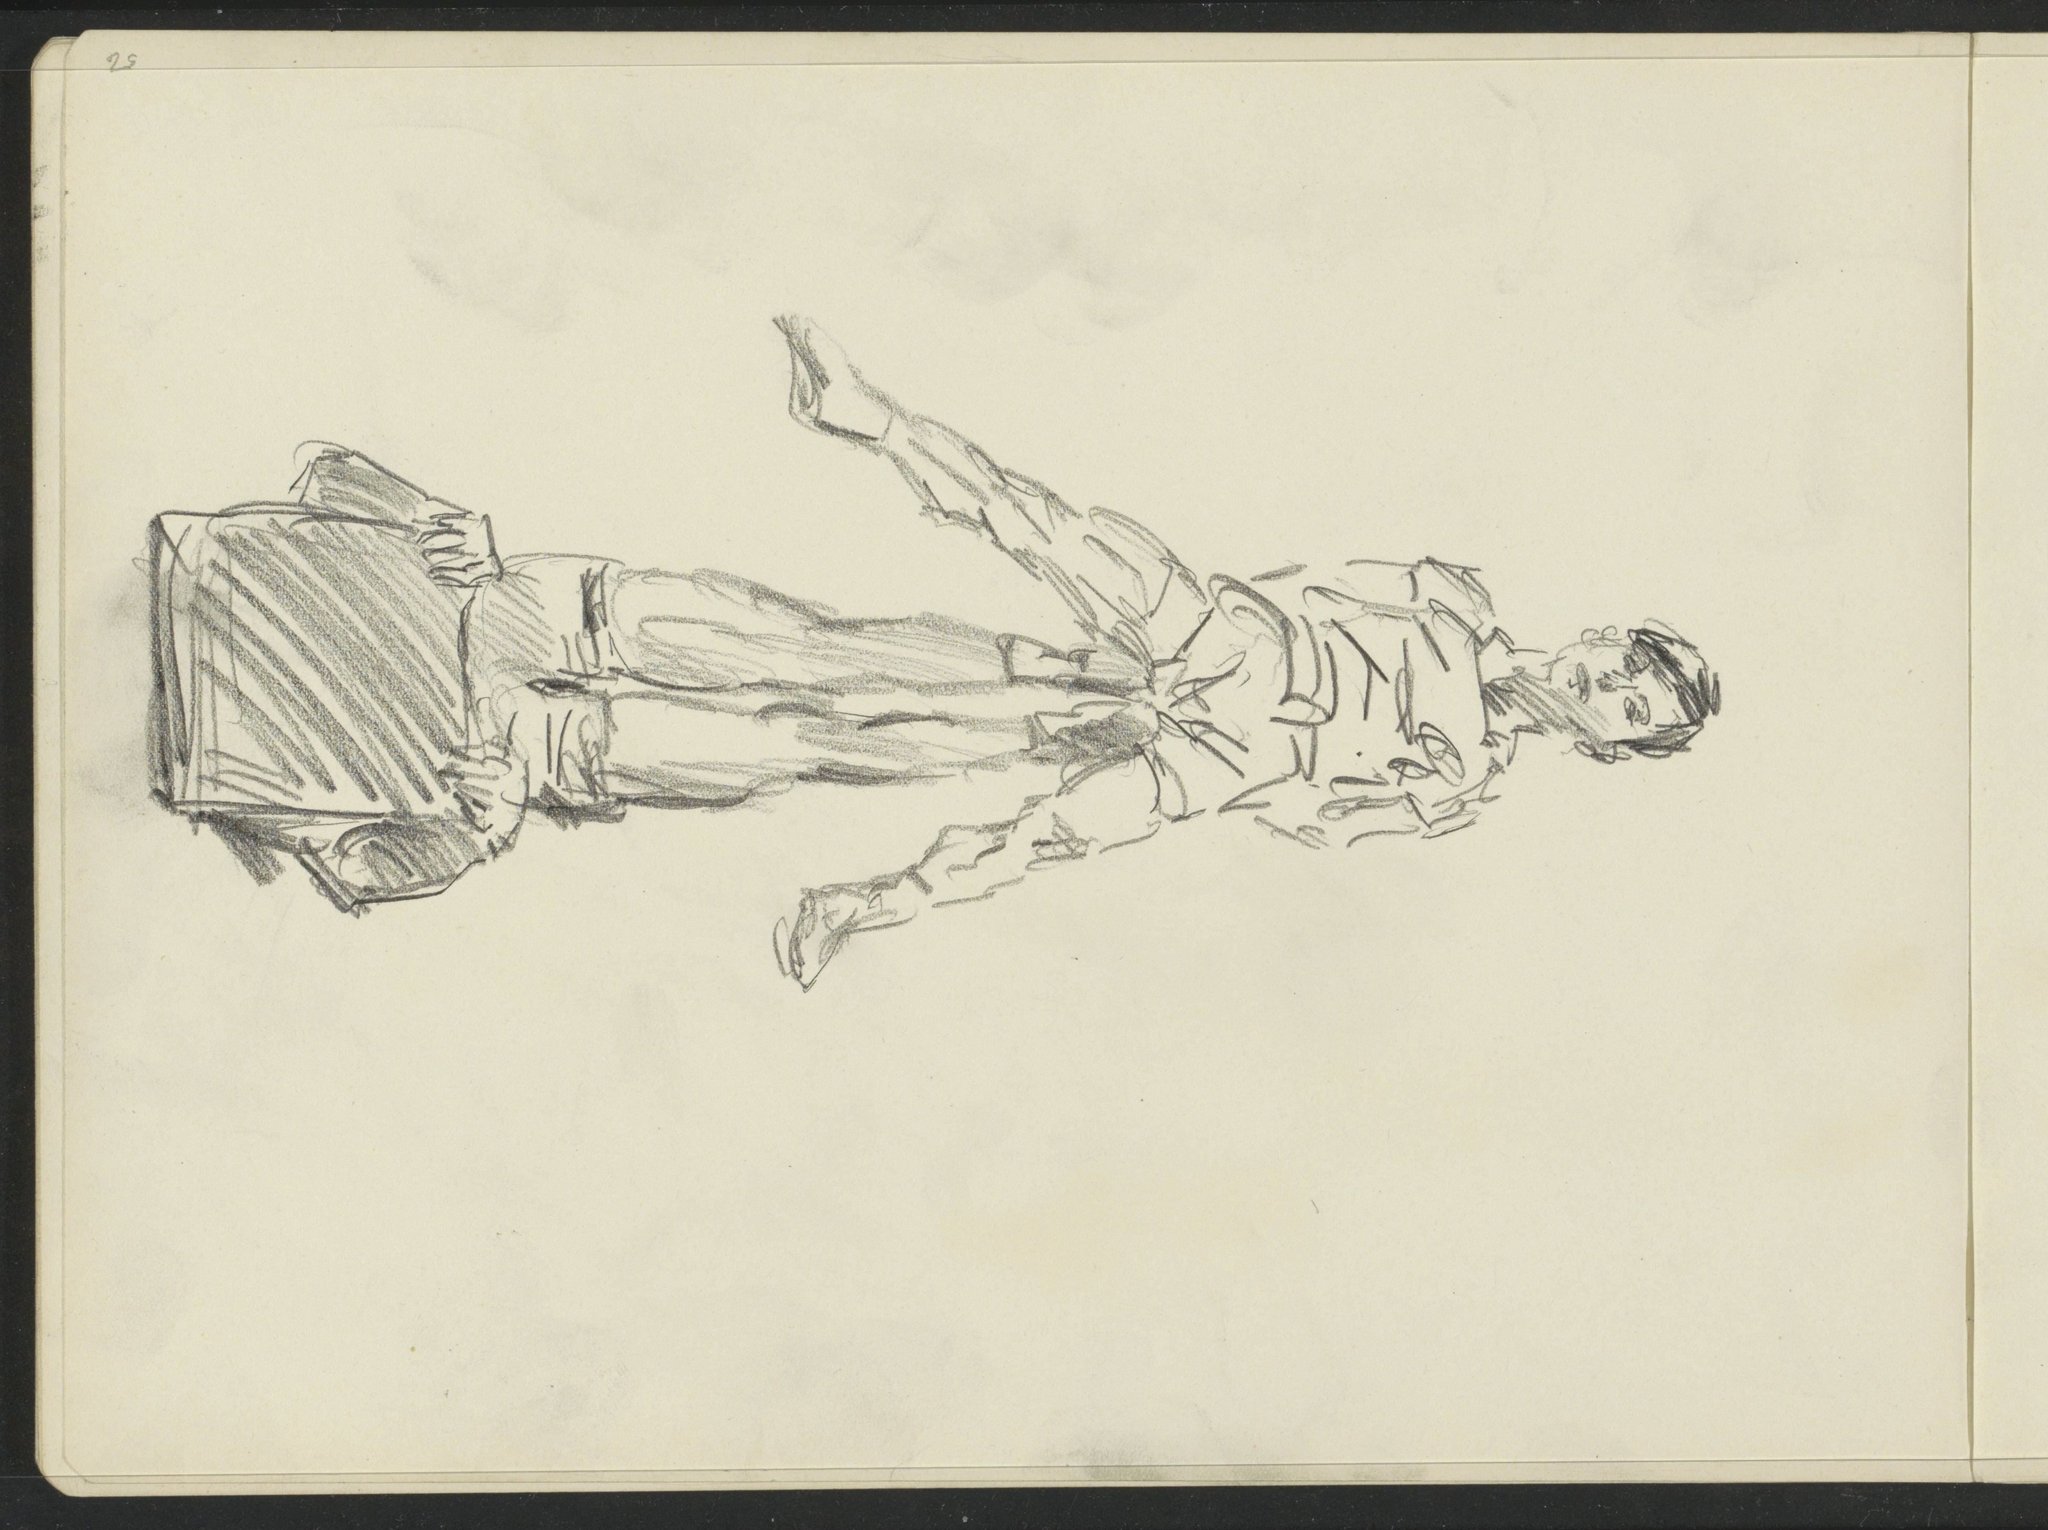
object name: sketchbook leaf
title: Twee acrobaten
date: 1915-1934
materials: paper, pencil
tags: adult man, acrobat ~ circus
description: Een acrobaat zit met gespreide benen op de voeten van een acrobaat in kaarshouding. Blad 9 verso uit schetsboek XVI met 32 bladen.